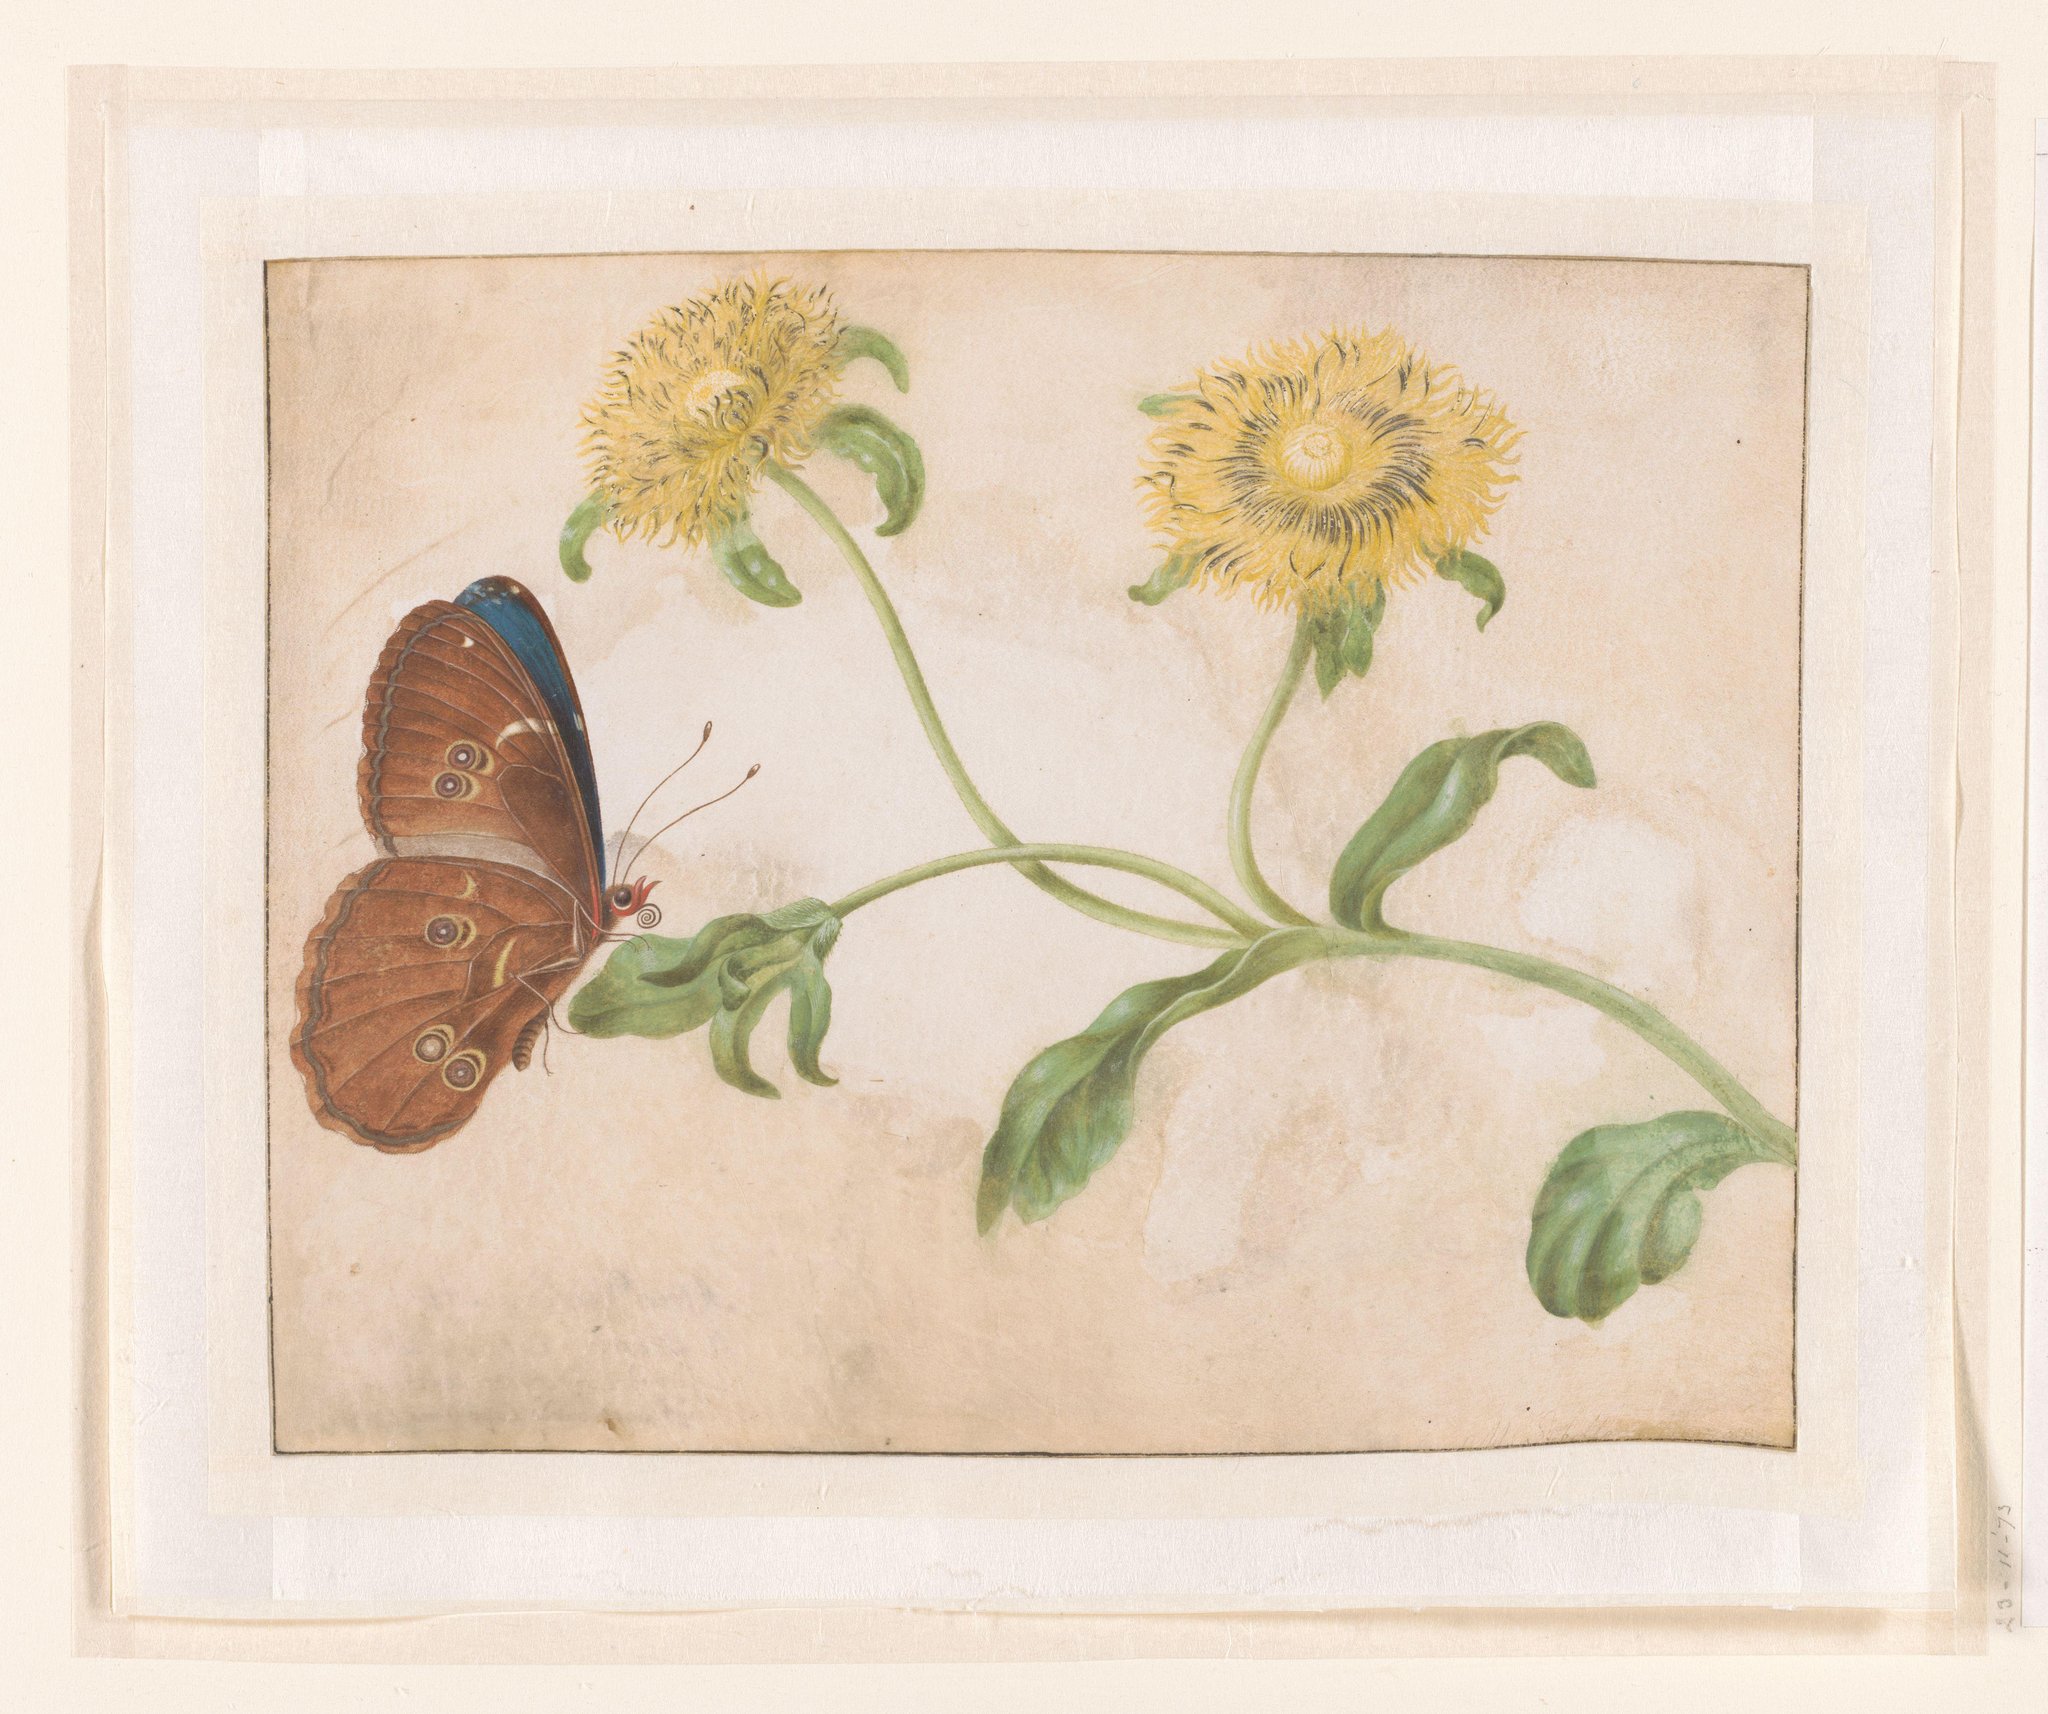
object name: drawing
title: Blue Morpho Butterfly on a Yellow Flower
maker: maria sibylla merian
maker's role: draughtsman, painter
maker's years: 1647-1717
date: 1696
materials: paint, gouache, parchment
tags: flowers, insects: butterfly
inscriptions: date, inscription: ‘'t schone Surinaamsche Capelle’